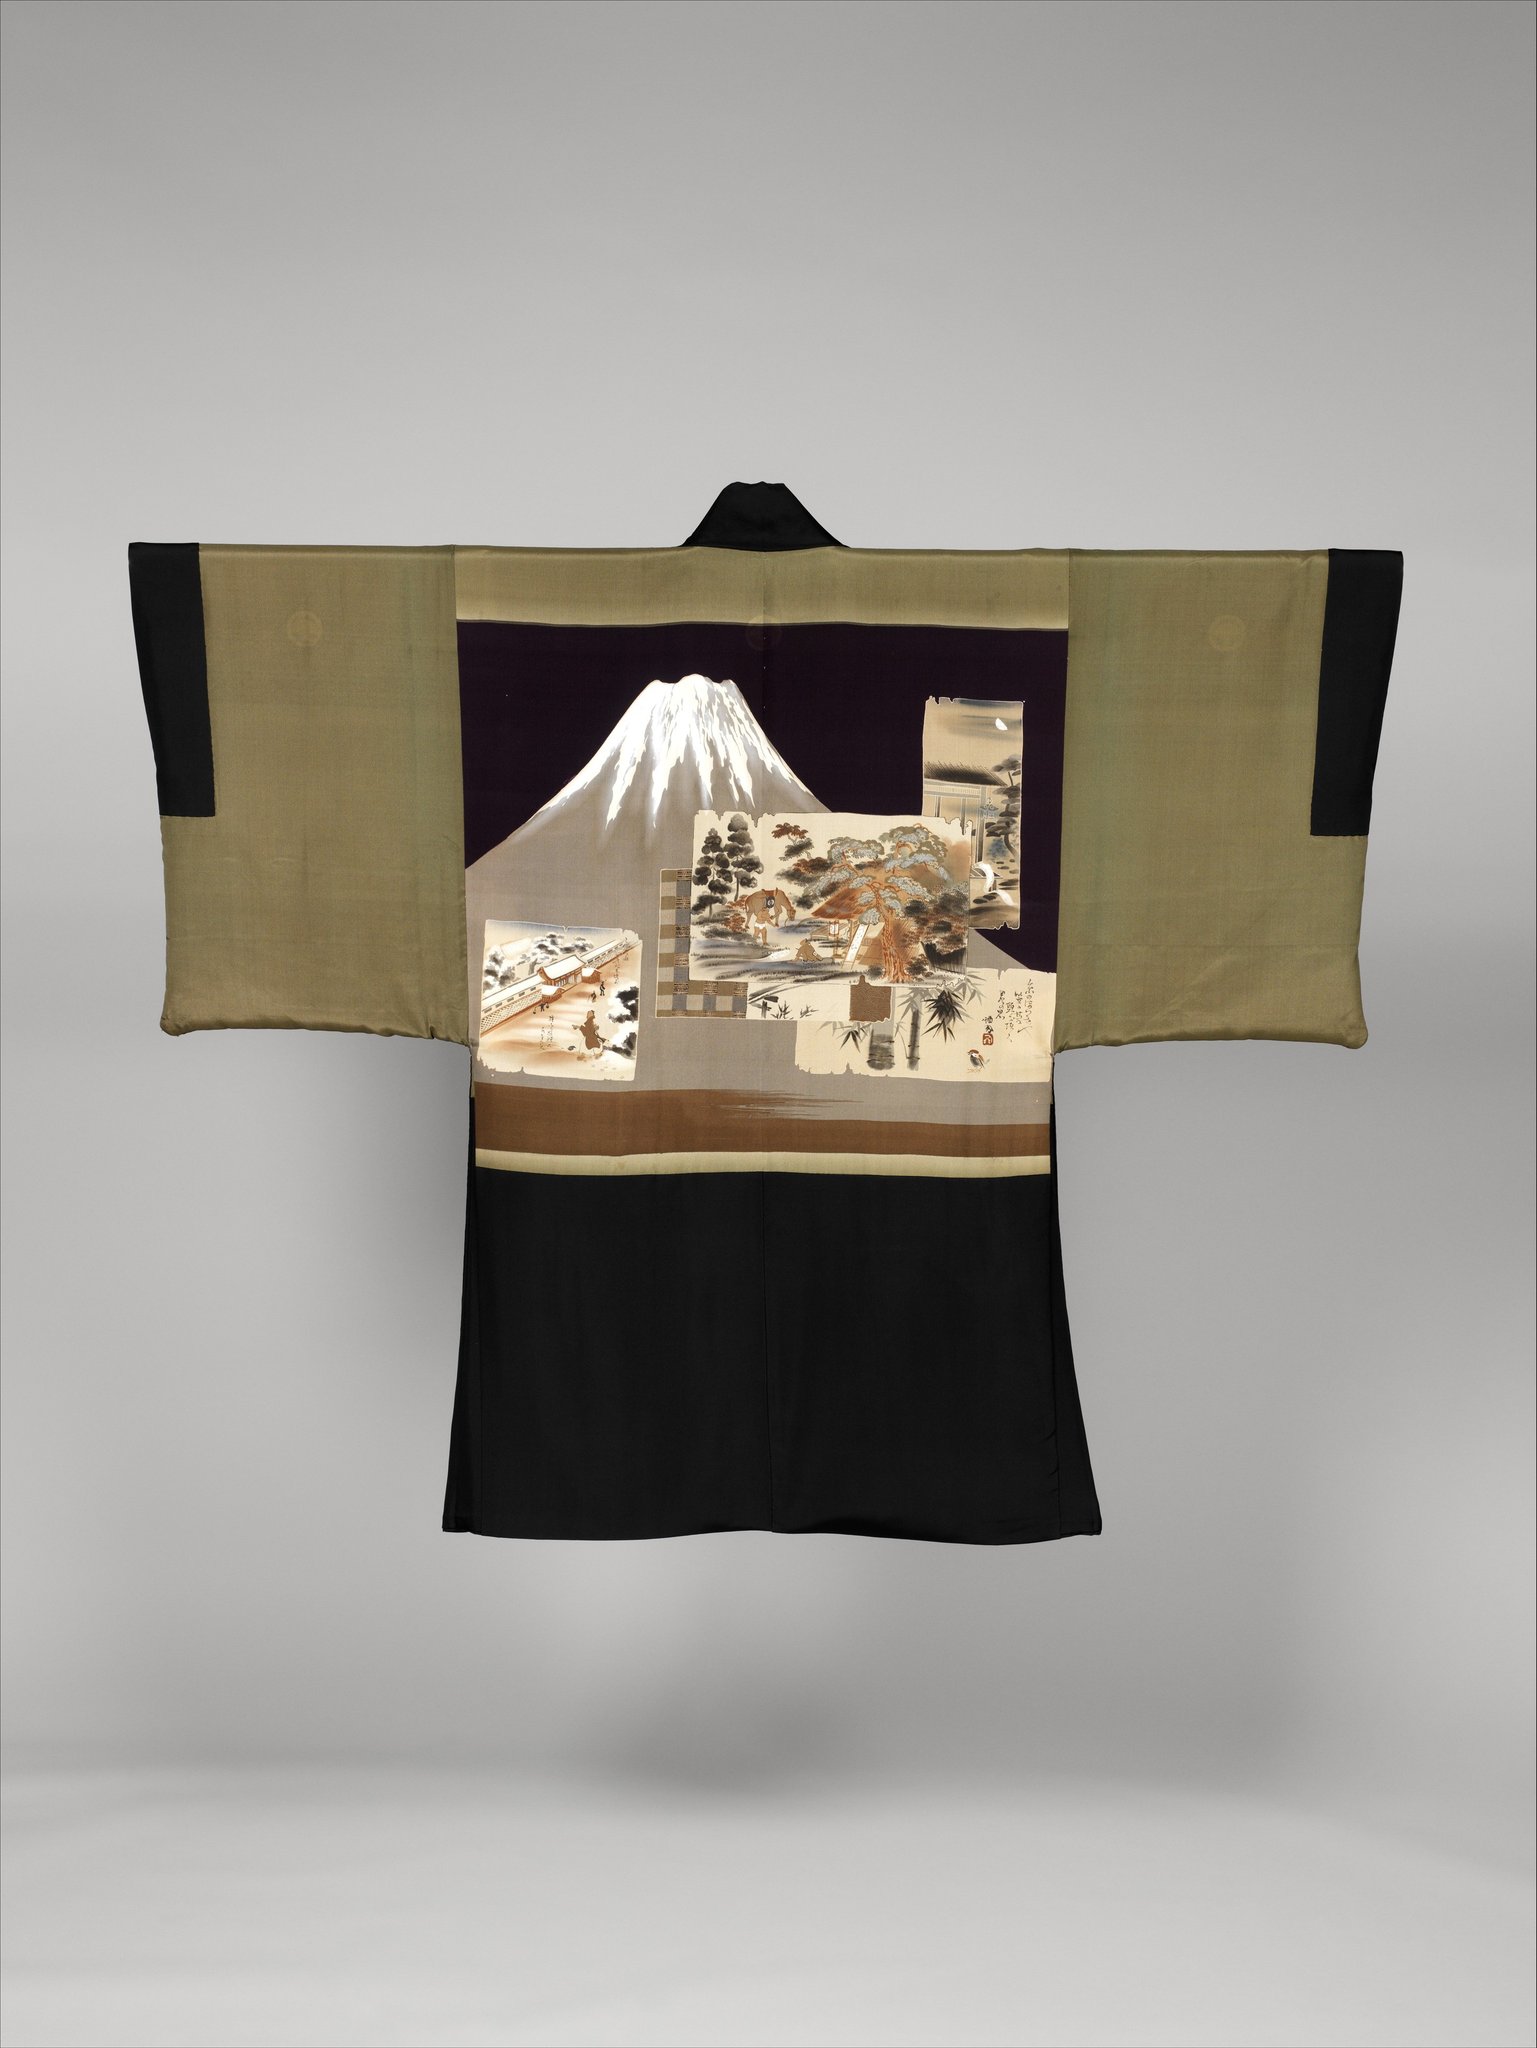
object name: man's formal jacket haori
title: Man's Formal Jacket (Haori)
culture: japanese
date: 1901-1933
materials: dye, silk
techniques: painting, weave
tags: volcanoes